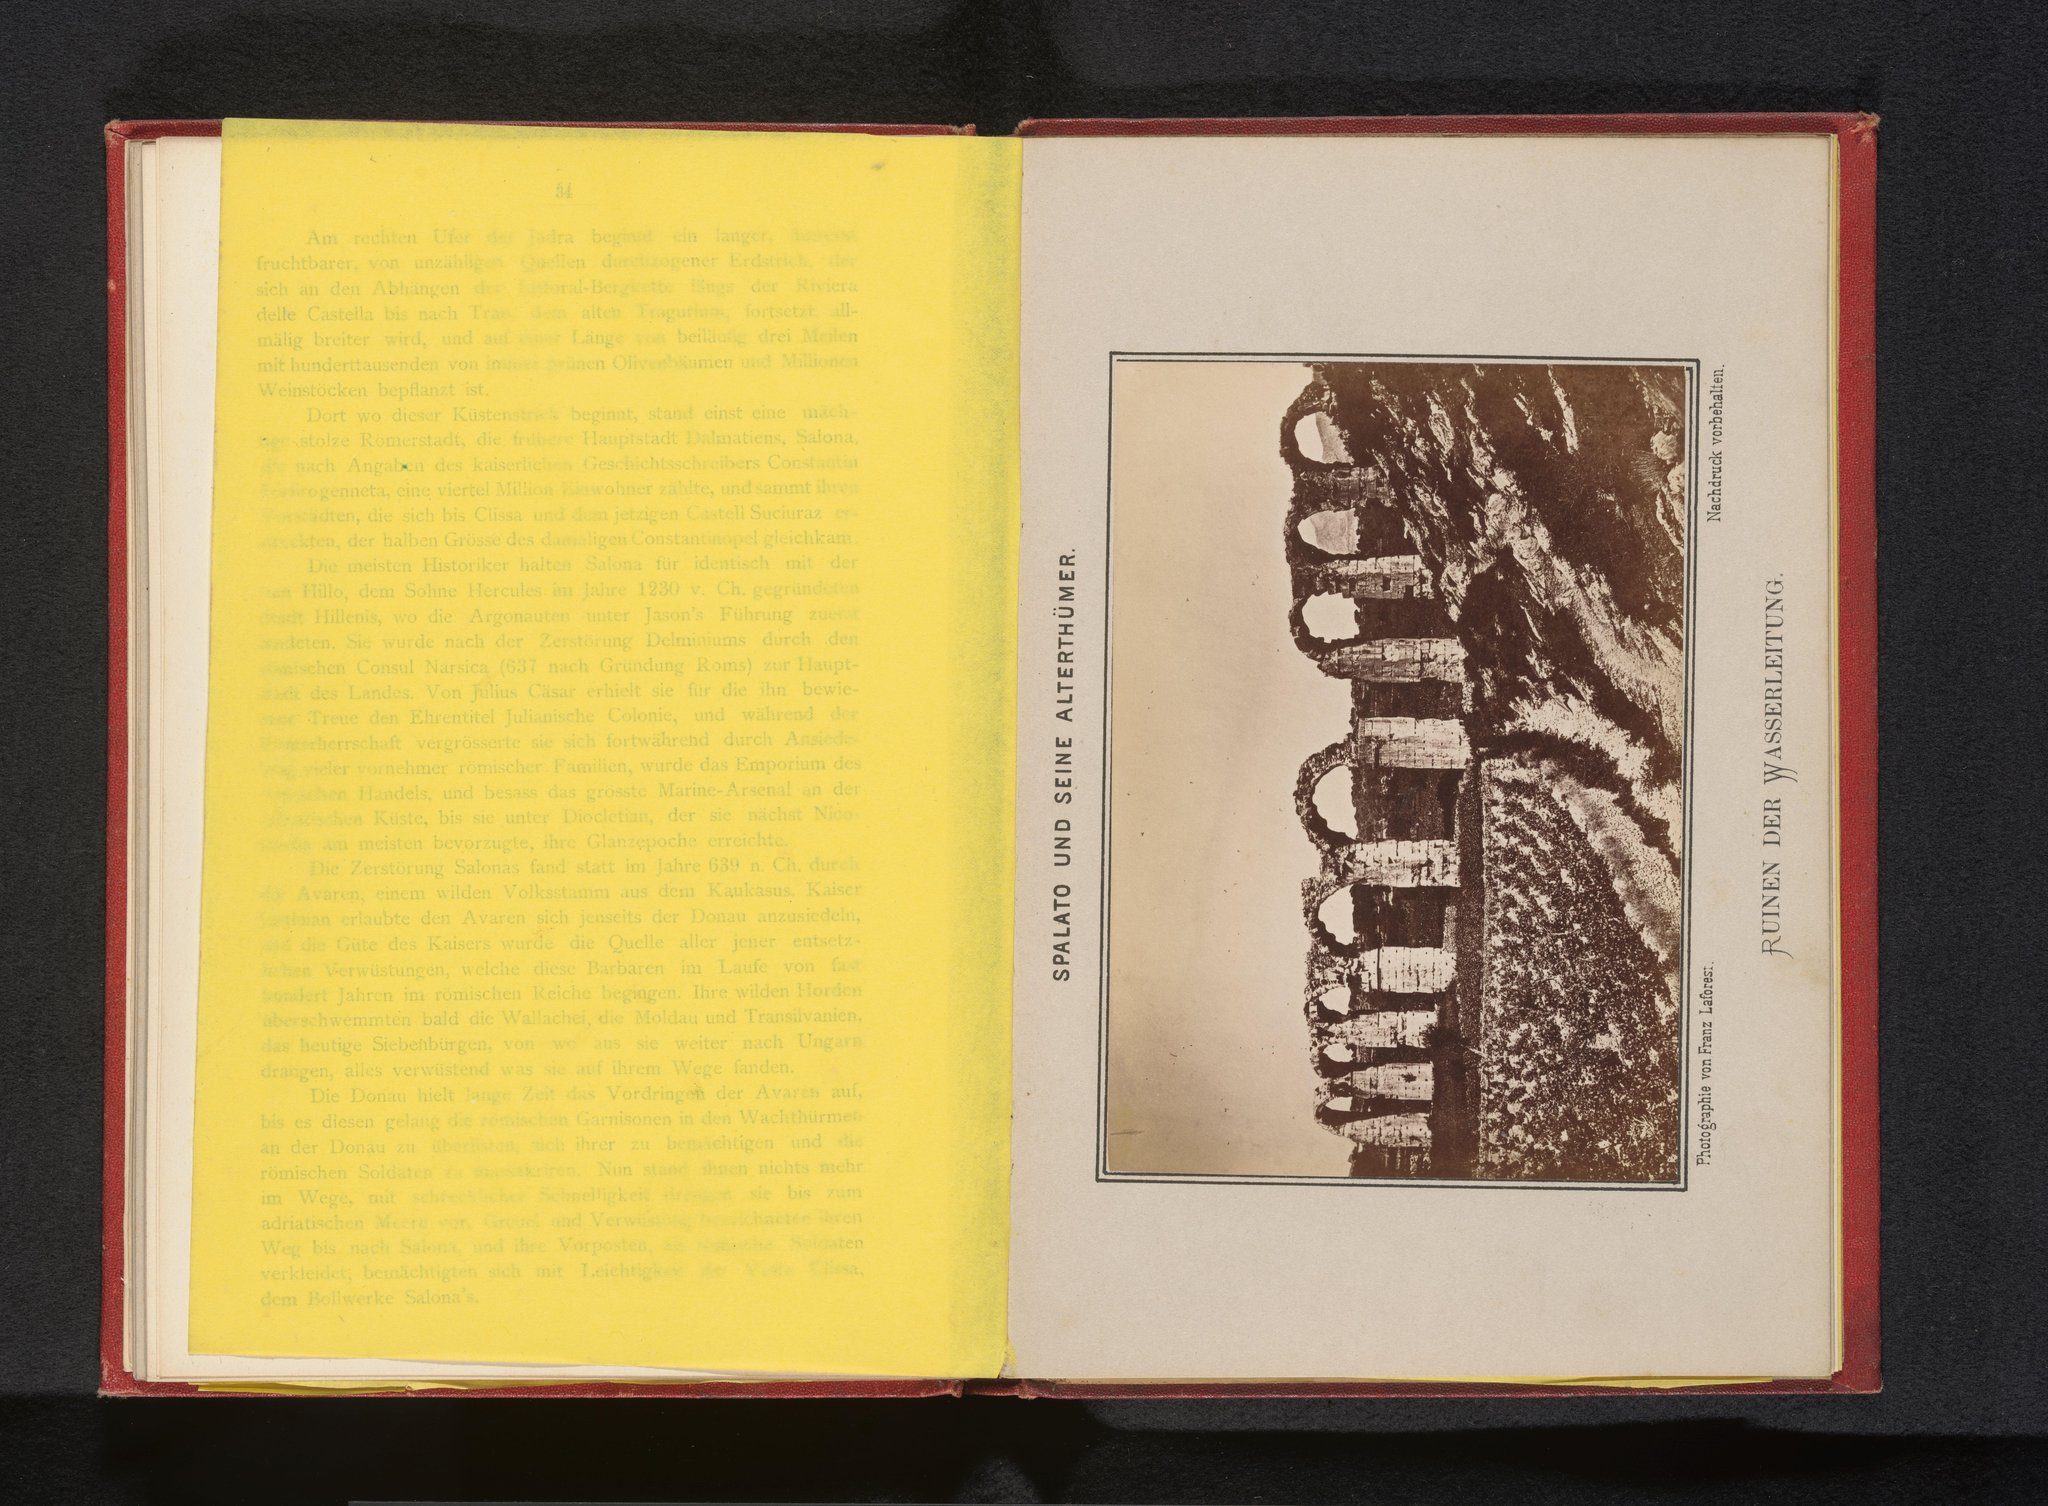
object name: page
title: Ruinen der Wasserleitung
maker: franz thiard de laforest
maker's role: fotograaf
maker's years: 1838-1911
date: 1868-1878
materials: photographic support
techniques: albumen print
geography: splitsko-dalmatinska županija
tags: aqueduct (~ water supply)